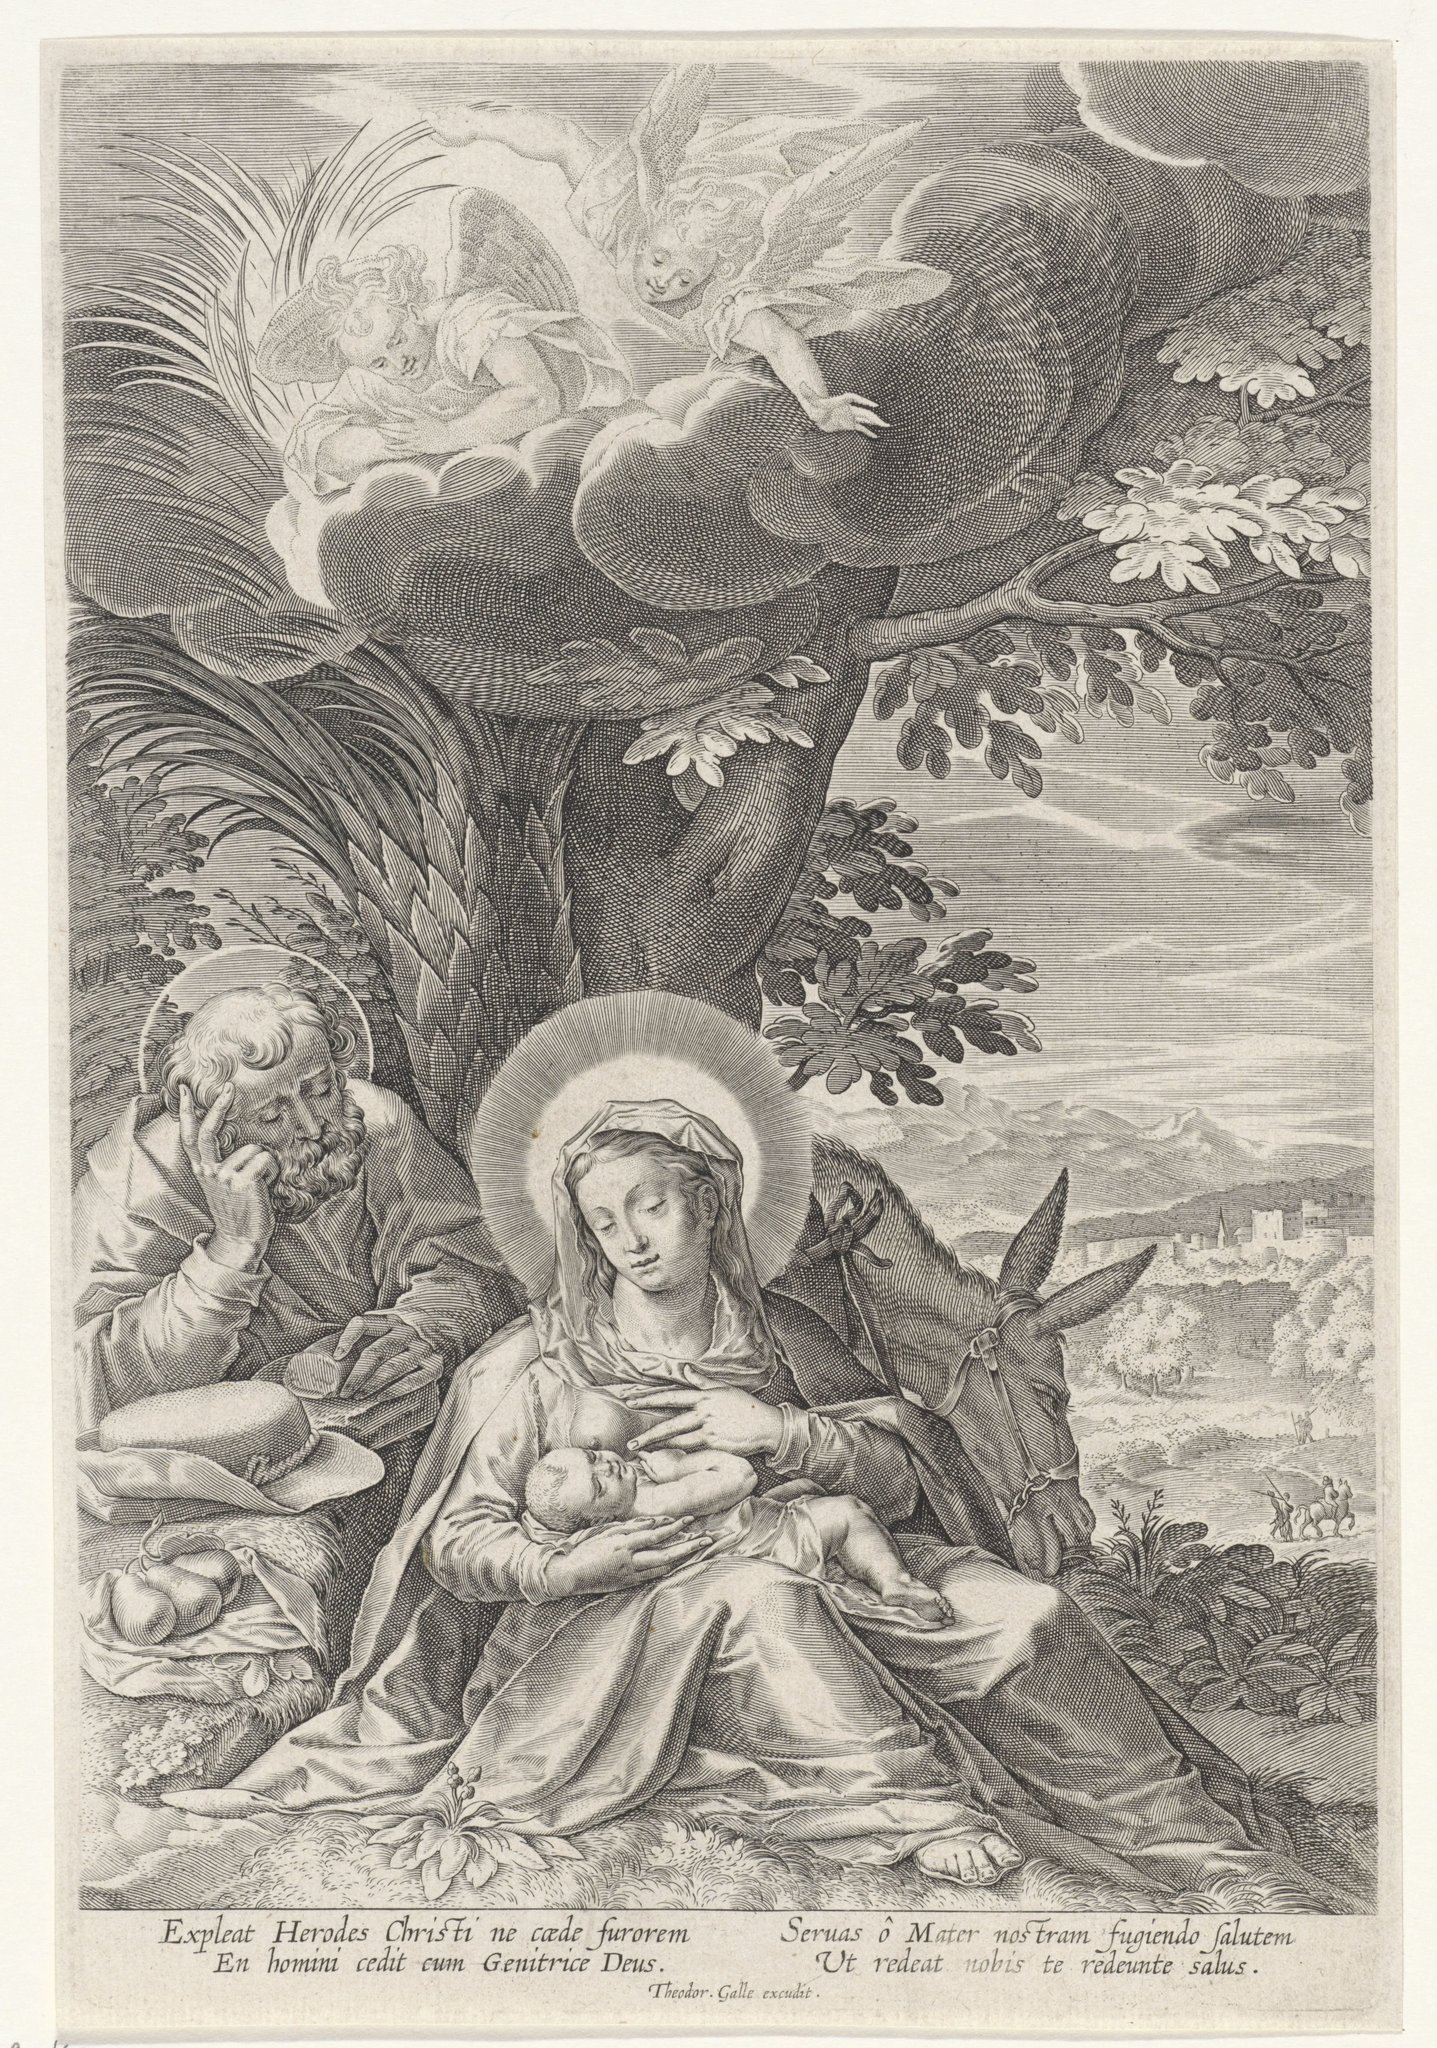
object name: print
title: Rust op de vlucht naar Egypte met engelen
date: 1587-1633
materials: paper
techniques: engraving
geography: munich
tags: rest on the flight into egypt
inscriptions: collector's mark: Lugt 2228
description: Heilige Familie rustend op de tocht naar Egypte. Maria voedt het Christuskind onder een palmboom. Bovenin de wolken twee engelen. Rechts een landschap